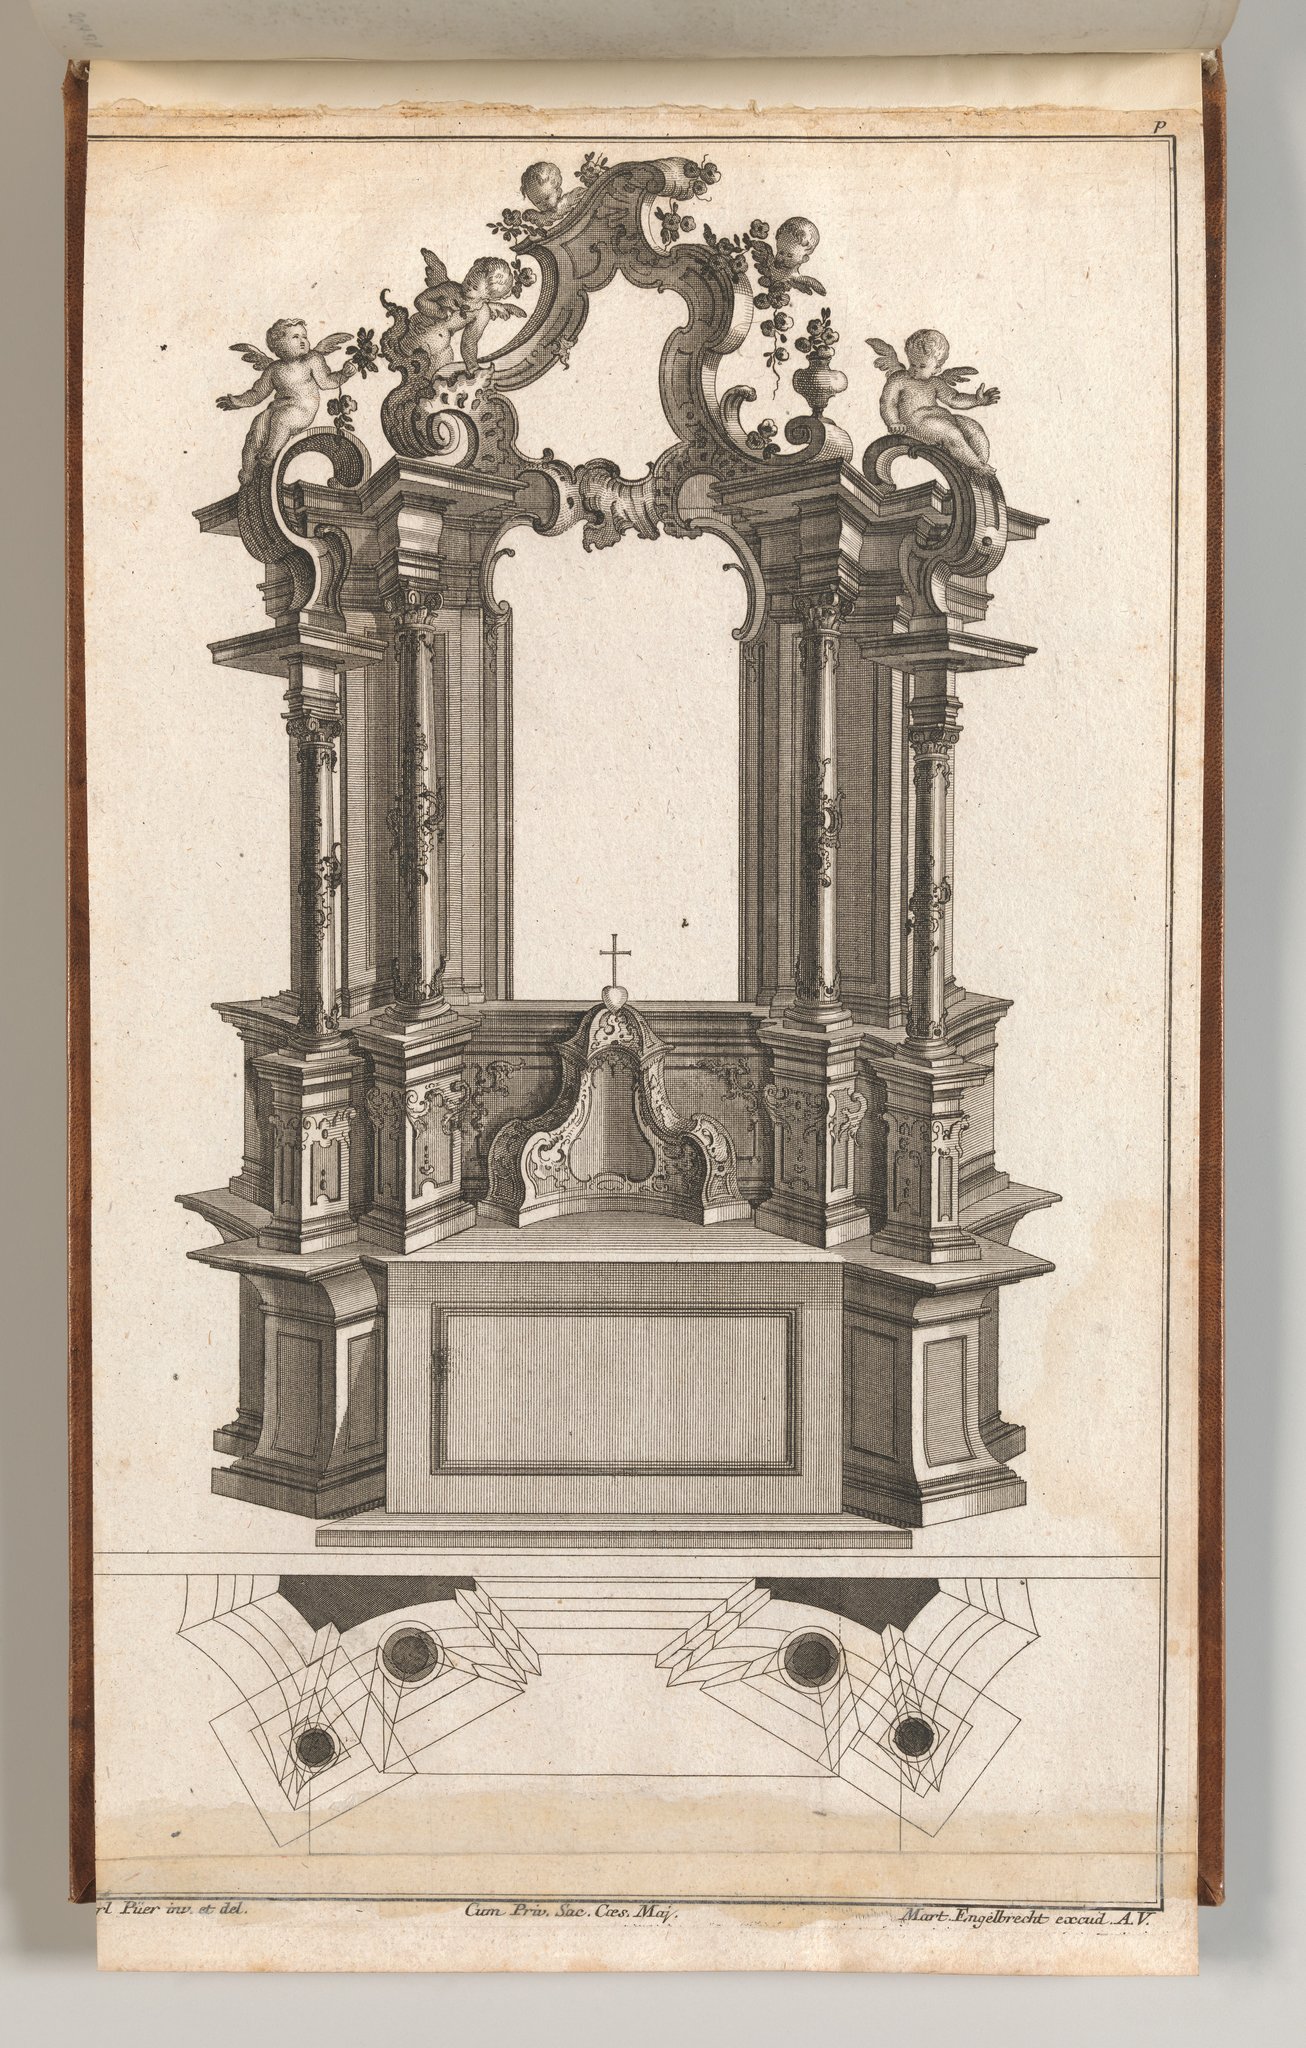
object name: album print ornament architecture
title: Design for a Monumental Altar, Plate 'p' from 'Unterschiedliche Neu Inventierte Altäre mit darzu gehörigen Profillen u. Grundrißen.'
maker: jacob gottlieb thelot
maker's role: engraver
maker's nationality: central european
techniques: etching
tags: altars